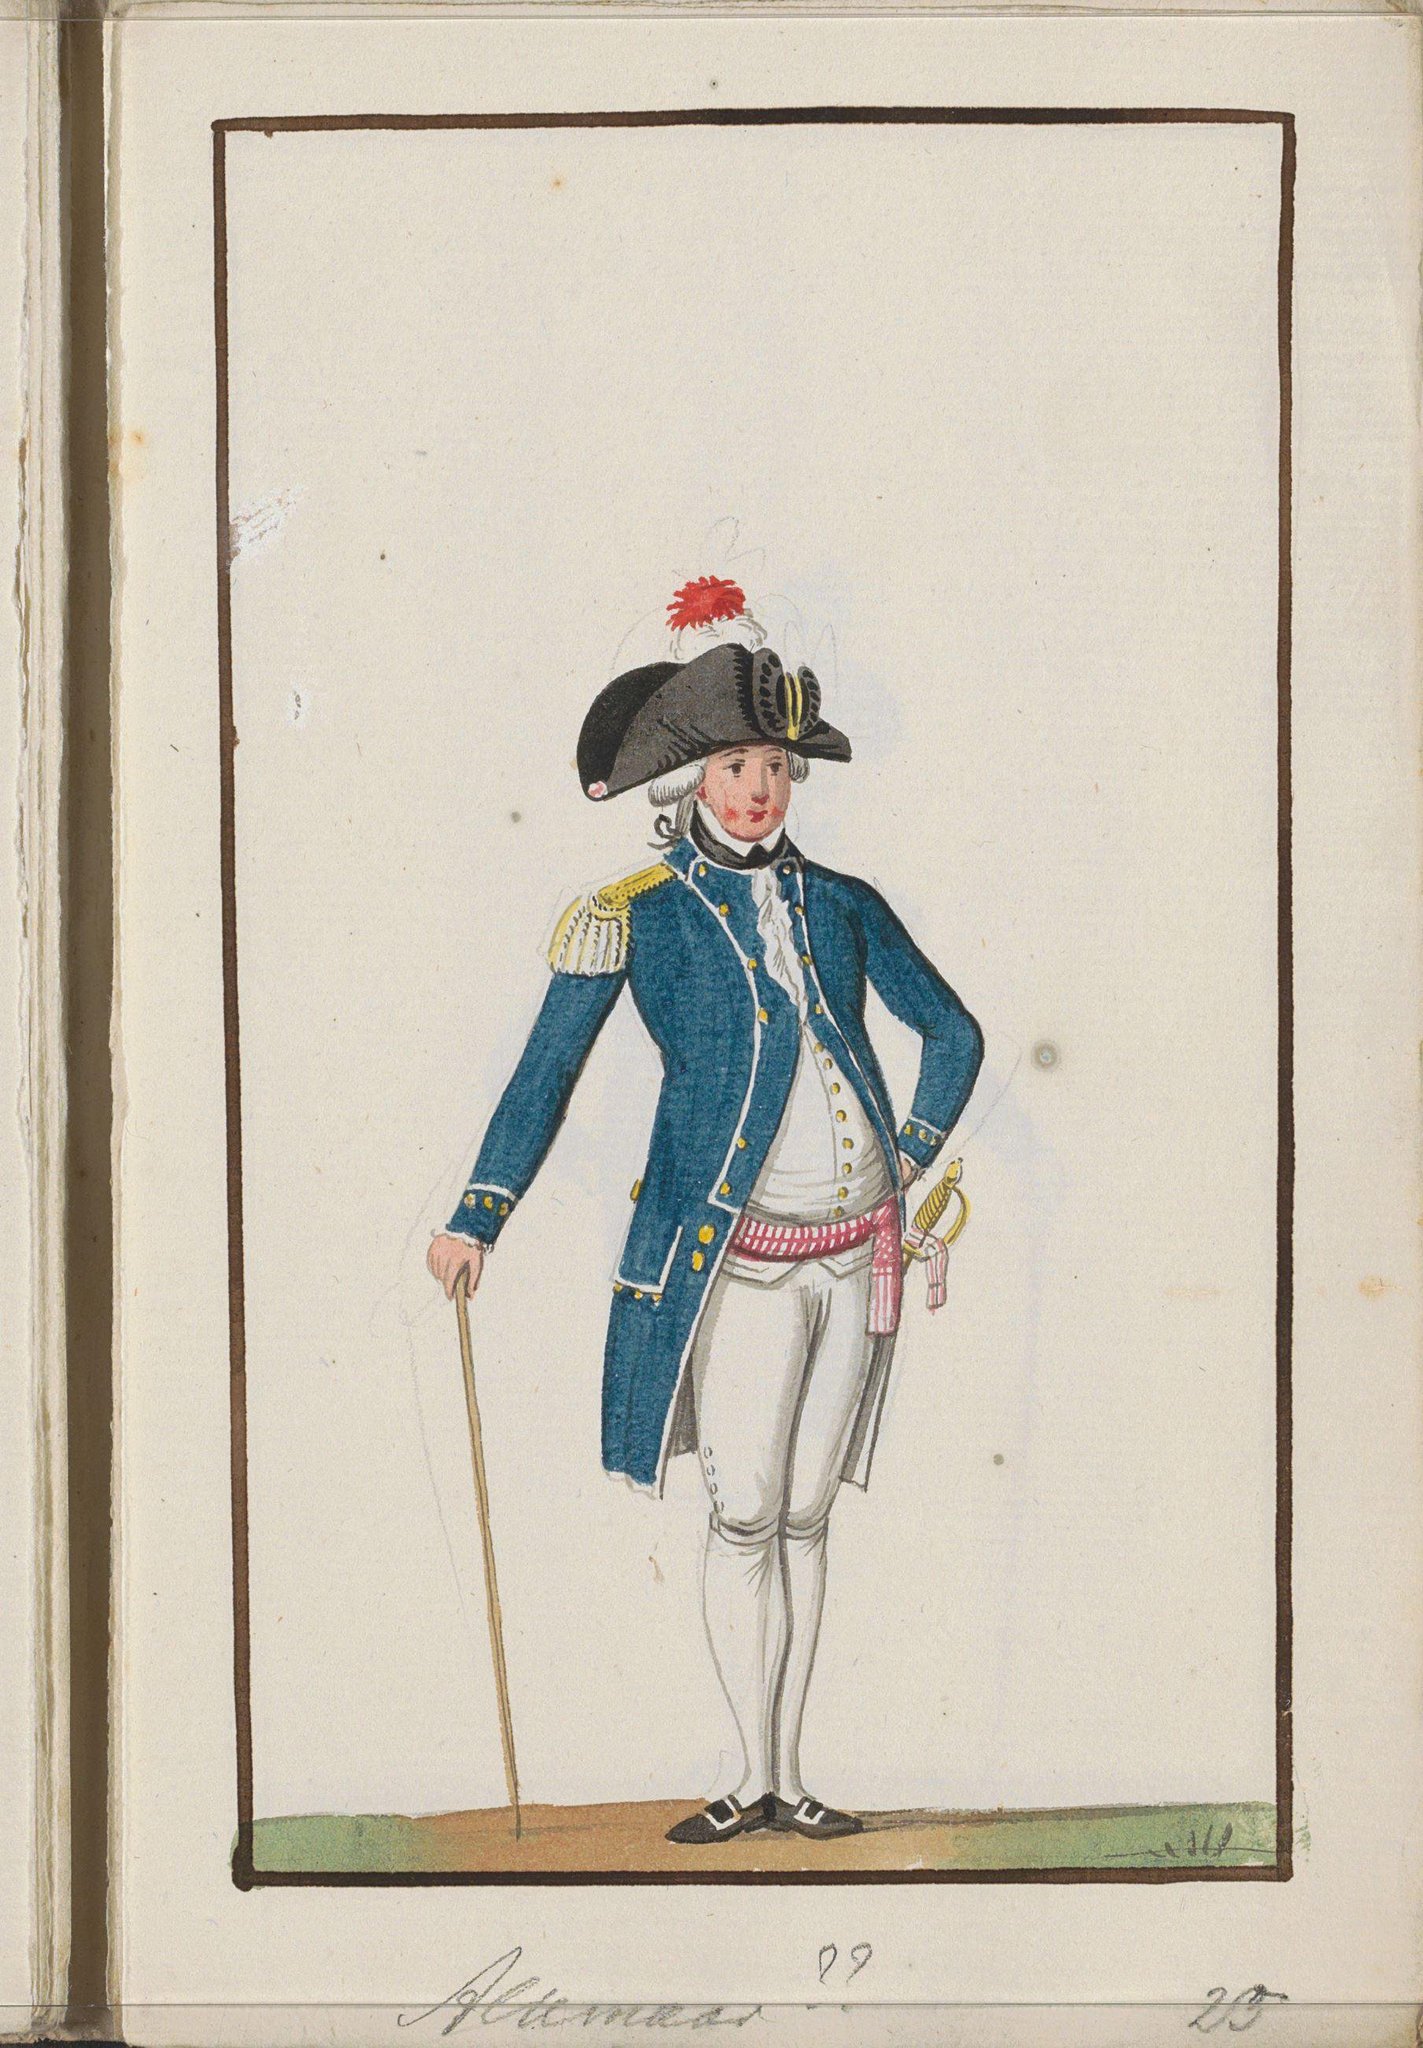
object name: costume print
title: Alkmaar Schuttery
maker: Anonymous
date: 1789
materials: paper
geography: northern netherlands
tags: (military) uniforms (+ citizen soldiery, civil guard, citizen militia), patriots (1780-1795)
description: Montering of uniform van de schutterij van Alkmaar, ca. 1785. Onderdeel van een schetsboek met 41 gekleurde tekeningen van de monteringen van de gewapende schutterijen en burgercorpsen in Nederland in de periode ca. 1783-1789.